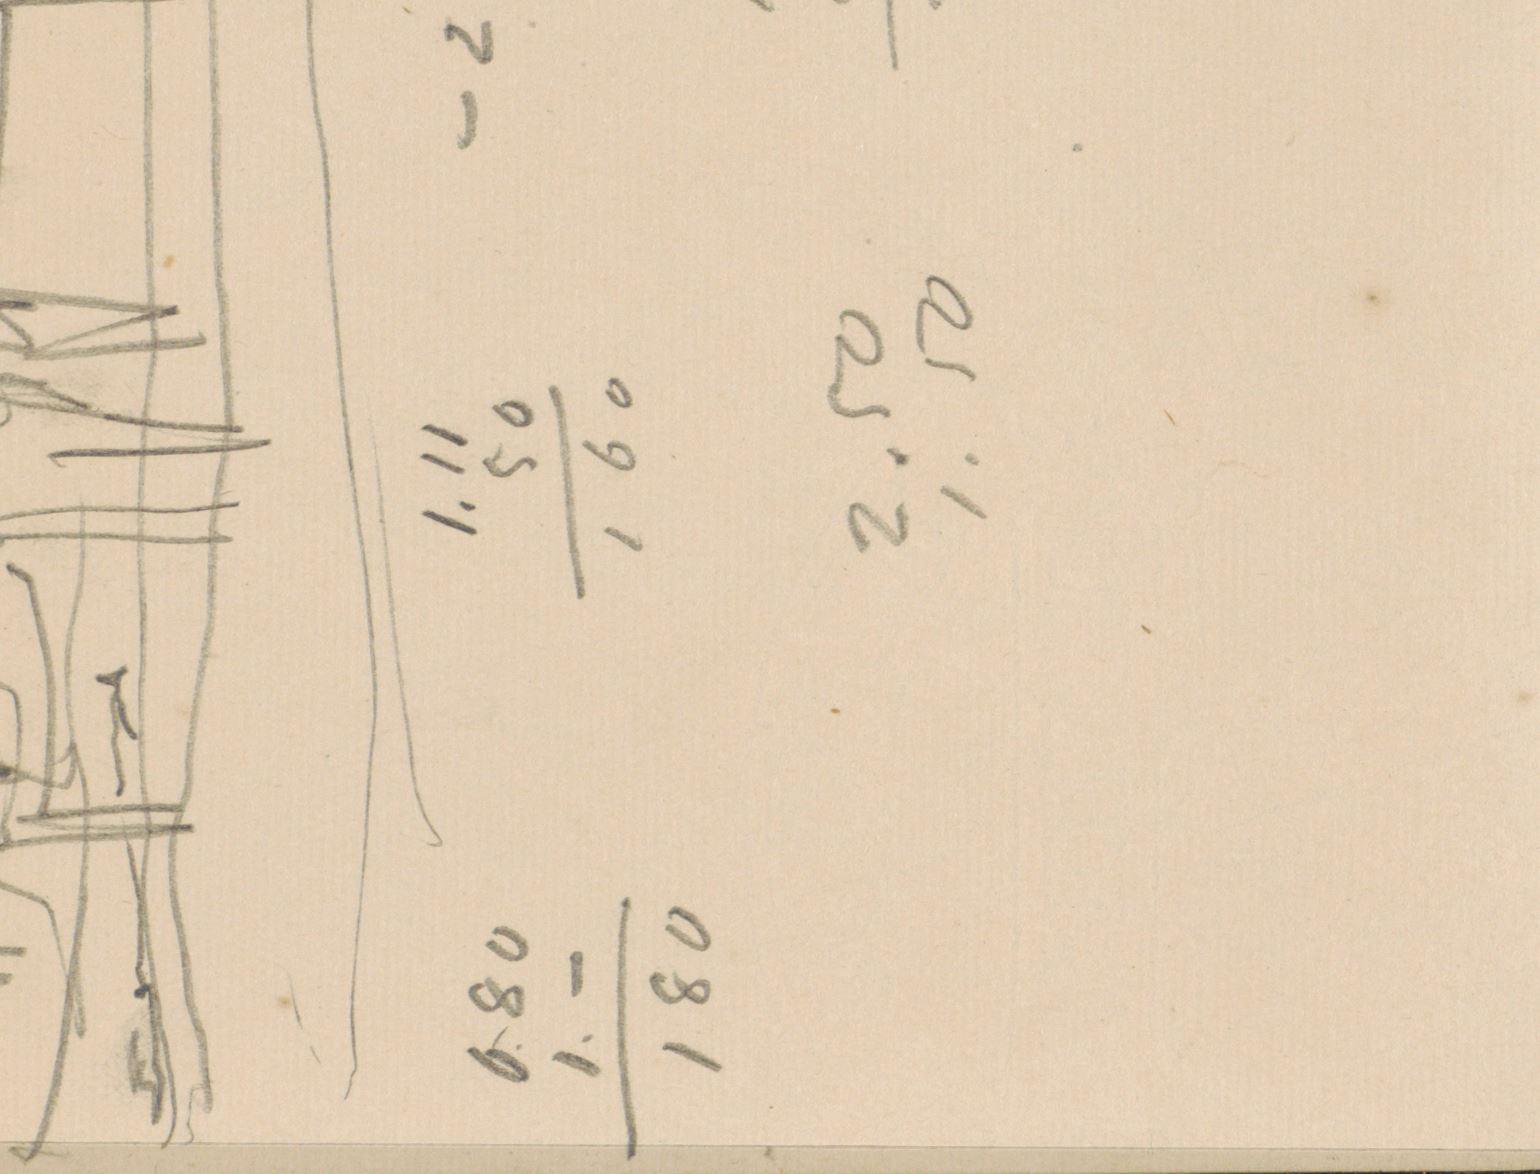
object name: sketchbook leaf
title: Ruiters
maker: george hendrik breitner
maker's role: draughtsman, painter, print maker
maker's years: 1857-1923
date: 1886-1903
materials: paper, pencil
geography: amsterdam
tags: riding a horse, ass, or mule; rider, horseman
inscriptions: annotation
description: Pagina 29 uit een schetsboek met 32 bladen.